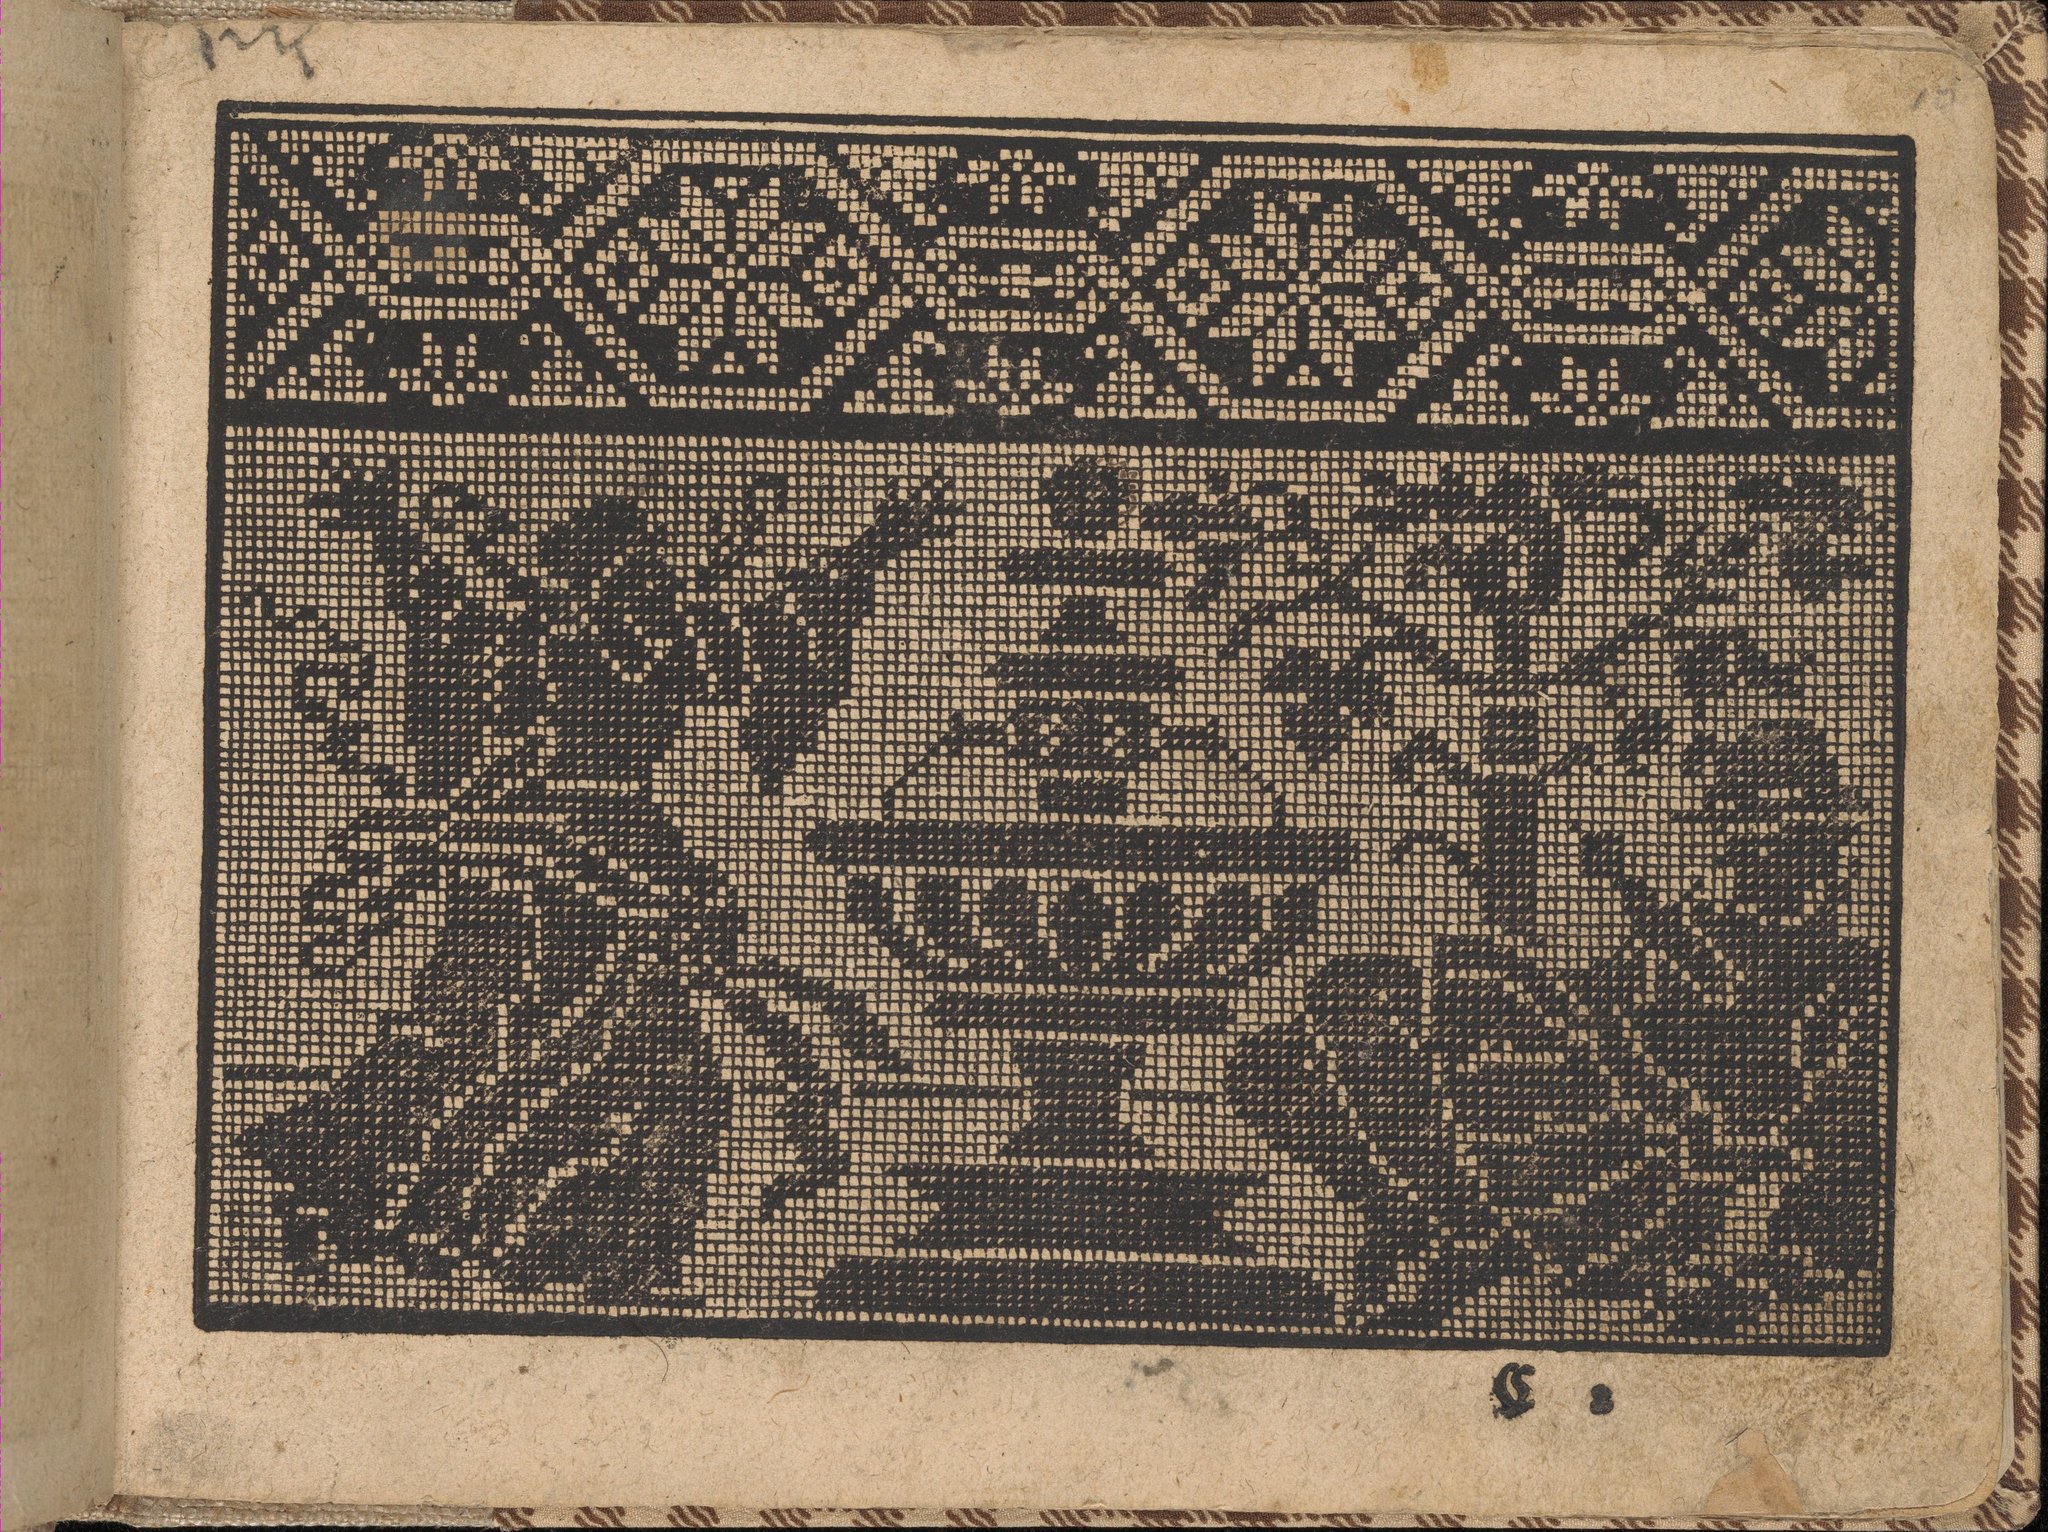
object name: book print ornament architecture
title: New Künstlichs Modelbuch (Page 10 recto)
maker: bernhard jobin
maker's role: publisher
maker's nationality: swiss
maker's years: 1535-1597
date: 1600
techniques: woodcut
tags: human figures